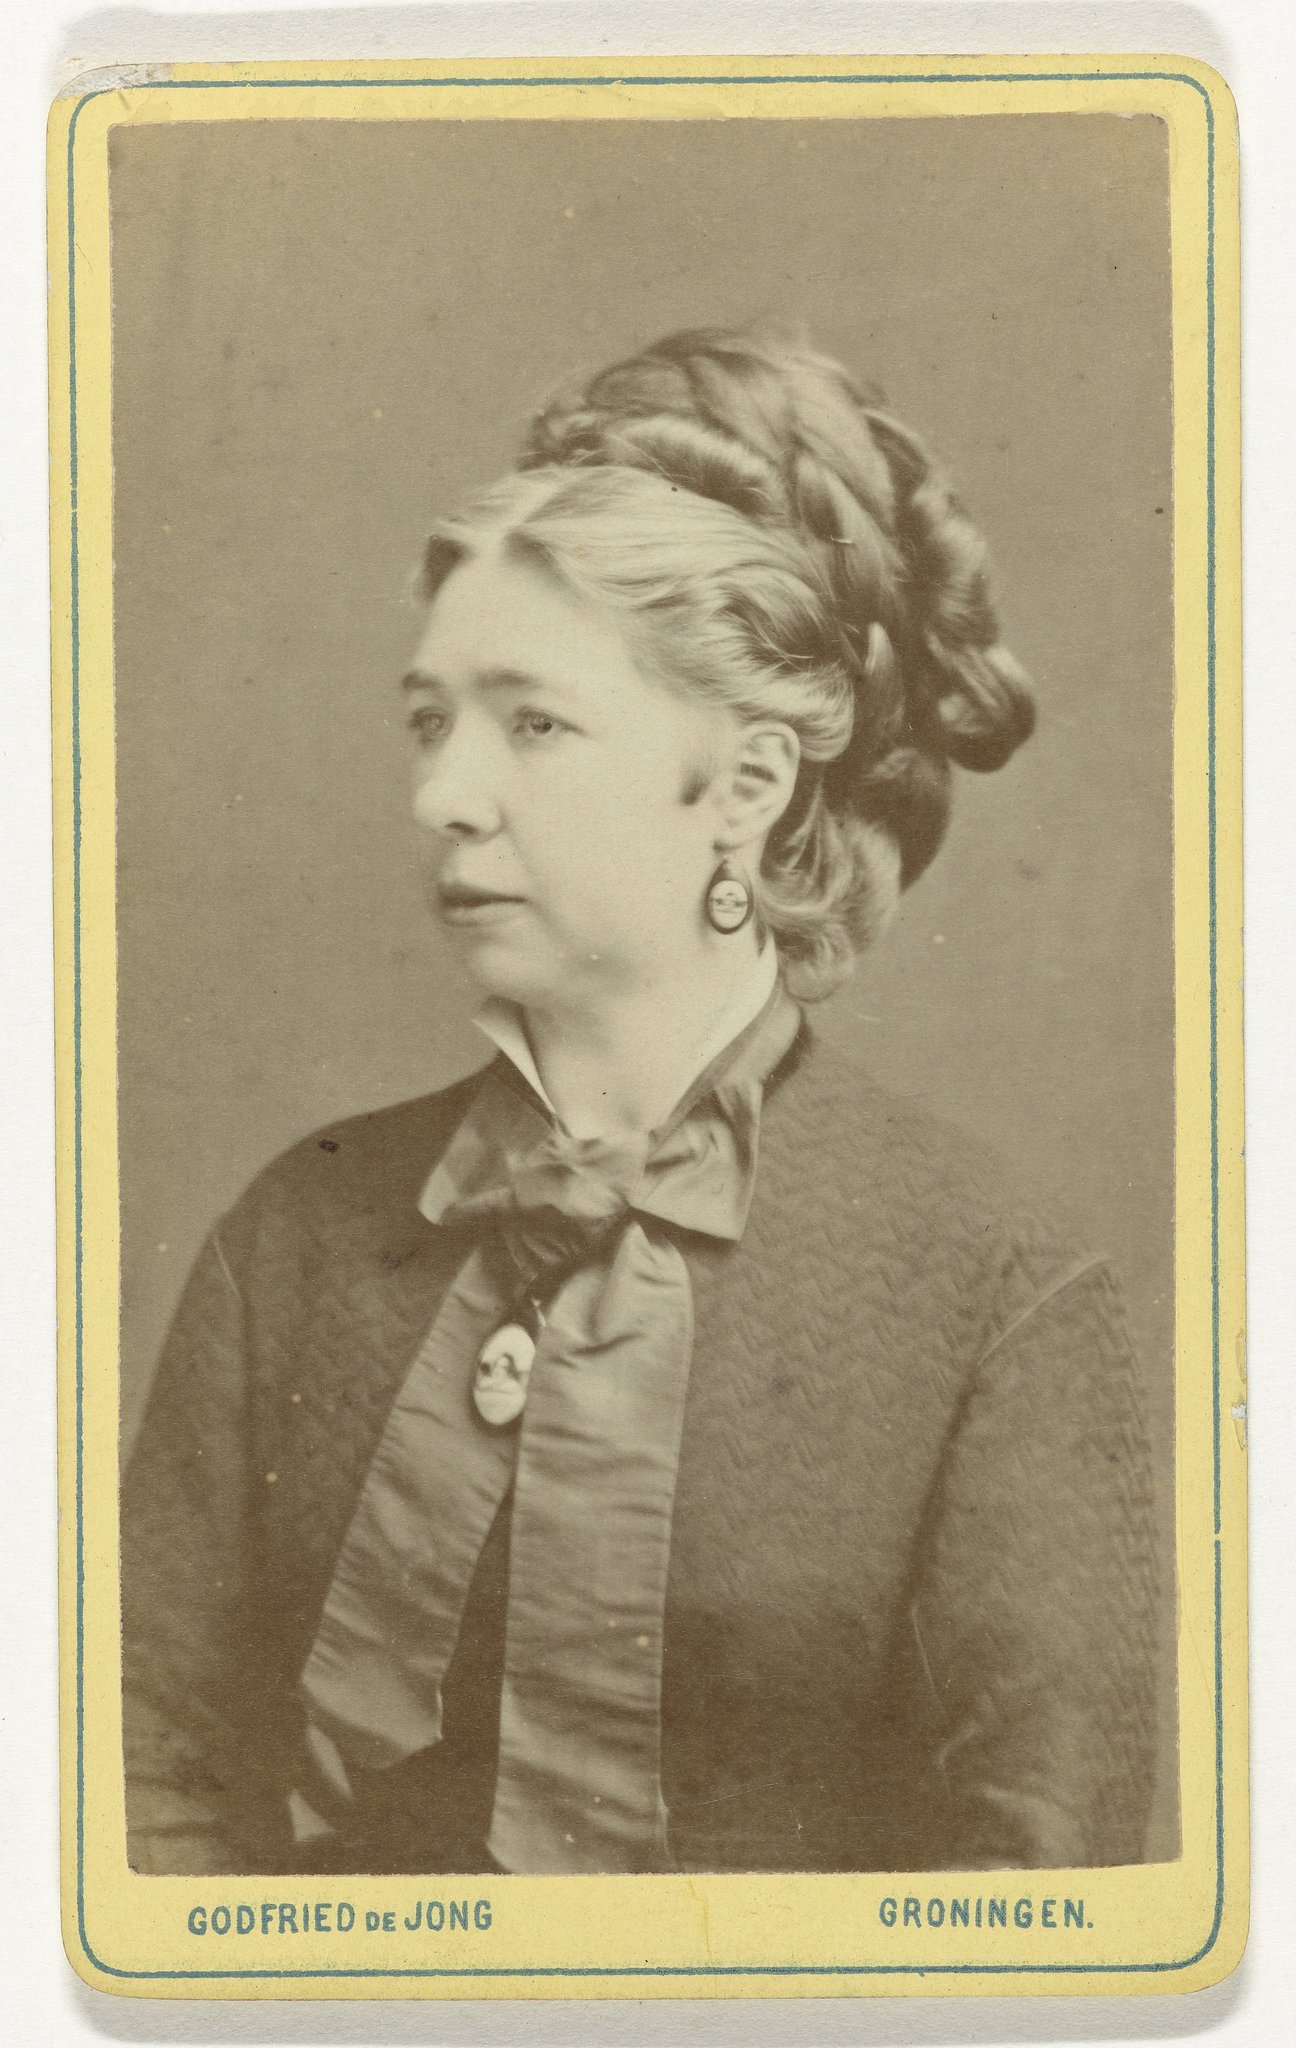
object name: photograph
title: Portret van een vrouw (Gelderman)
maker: godfried de jong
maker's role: print maker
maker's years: 1832-1918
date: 1874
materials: cardboard, paper, photographic support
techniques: albumen print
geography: groningen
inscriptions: annotation: ‘f 150’, address: ‘Bekroond Internationale Tentoonstelling Amsterdam/1874/Godfried de Jong/Photographe-Artistique/Heerestraat/Groningen’, annotation: ‘Tante Gelderman’, annotation: ‘Van deze photographie kan nabesteld worden./Vergroting naar visite kaarten in alle afmetingen.’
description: Buste van een vrouw met hoog opgestoken haar, grote hanger met bijpassende oorbellen.